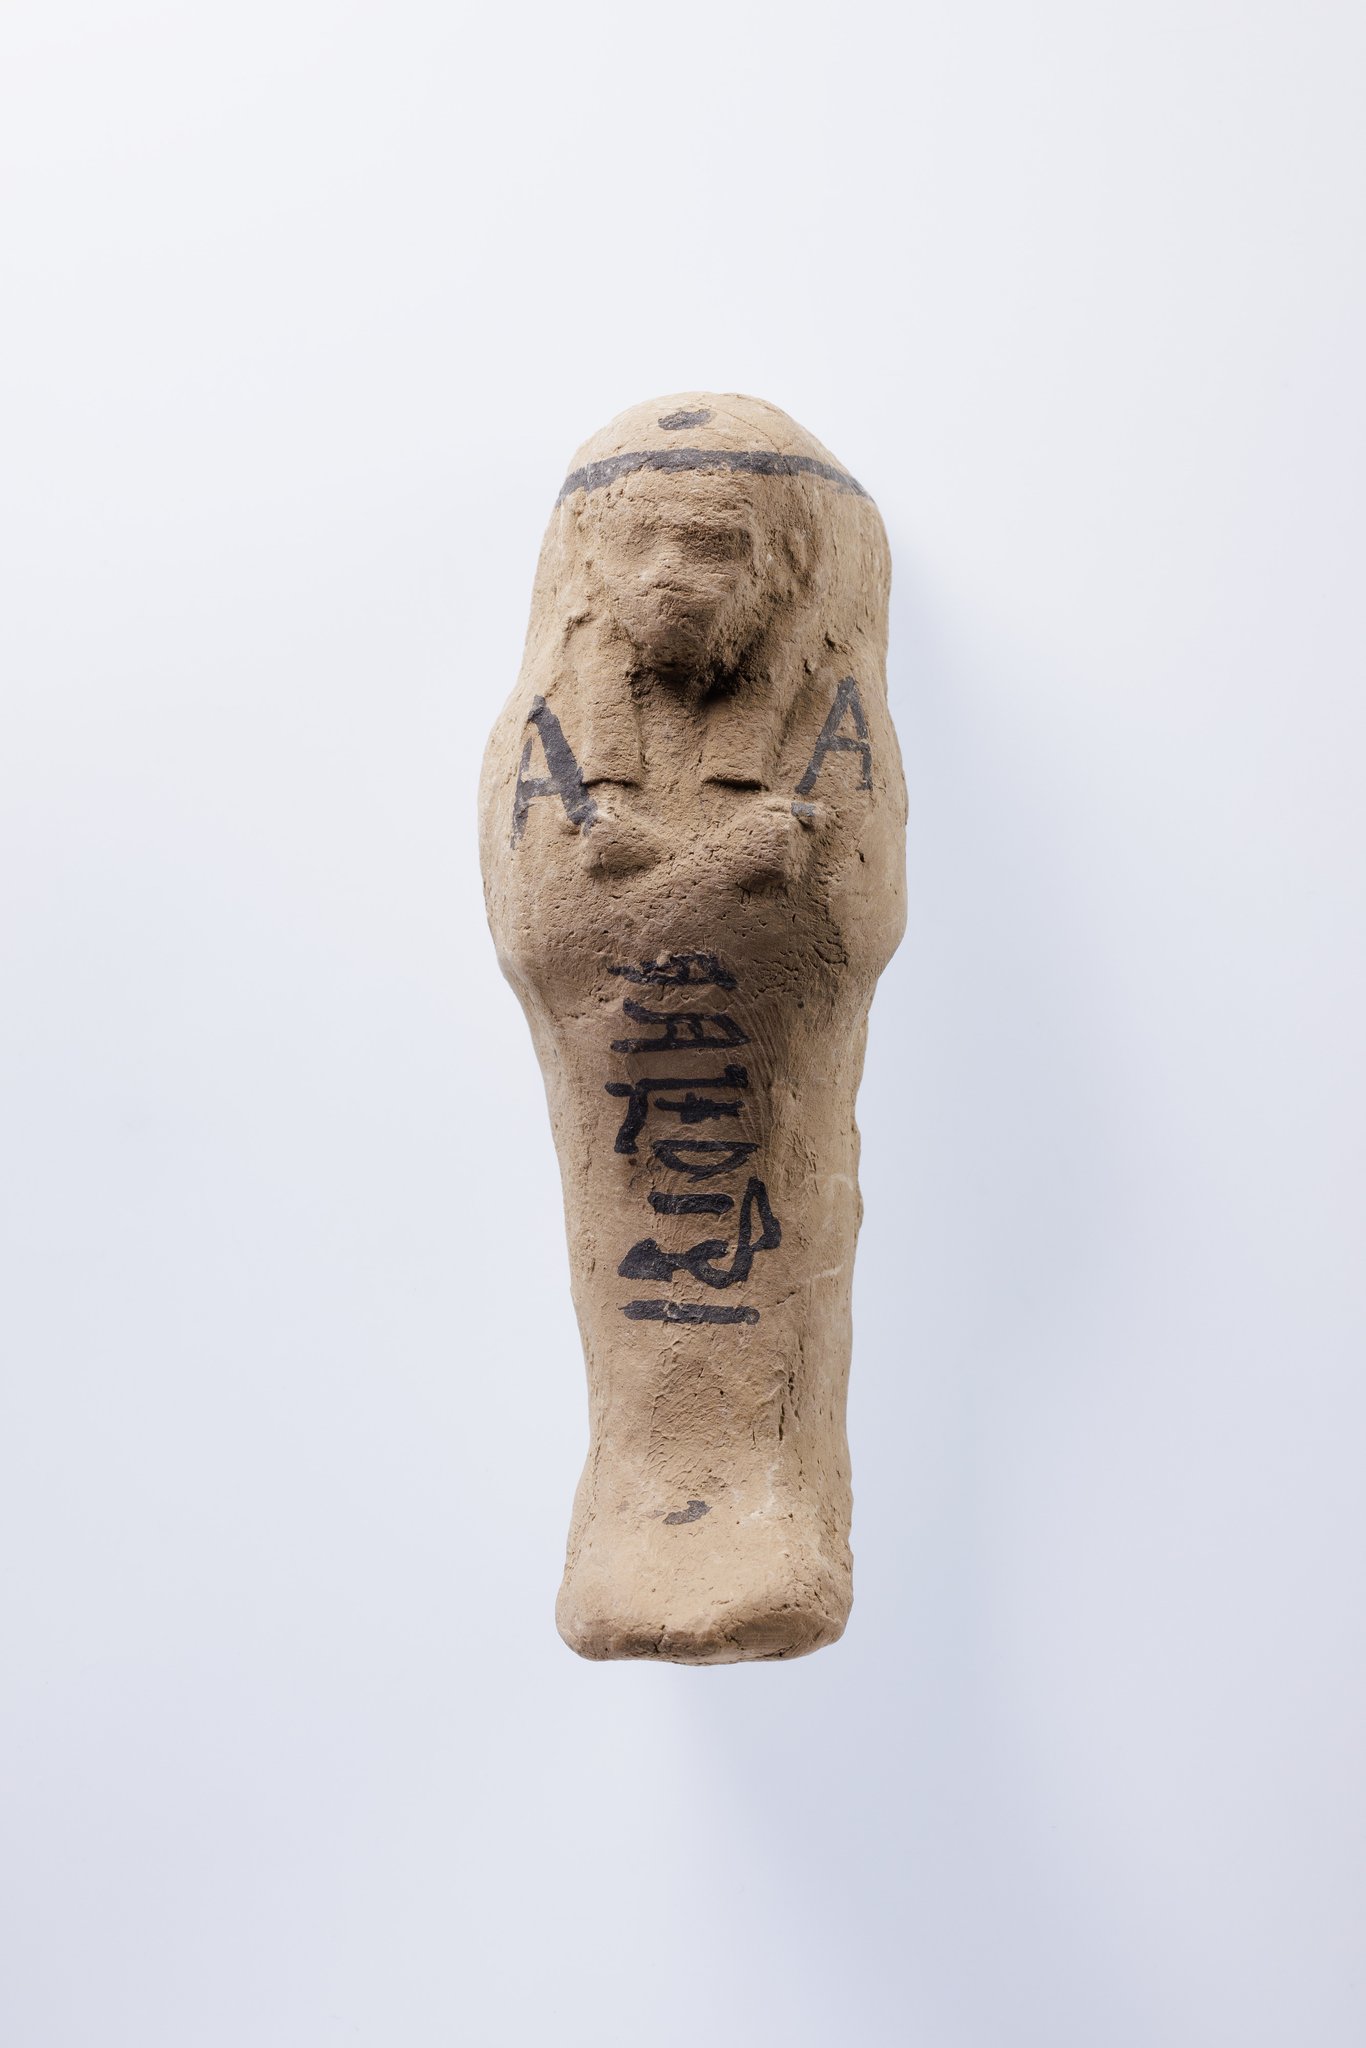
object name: shabti, nesinebtasheru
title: Shabti of Nesinebtasheru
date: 1070-945 BCE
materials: clay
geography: egypt